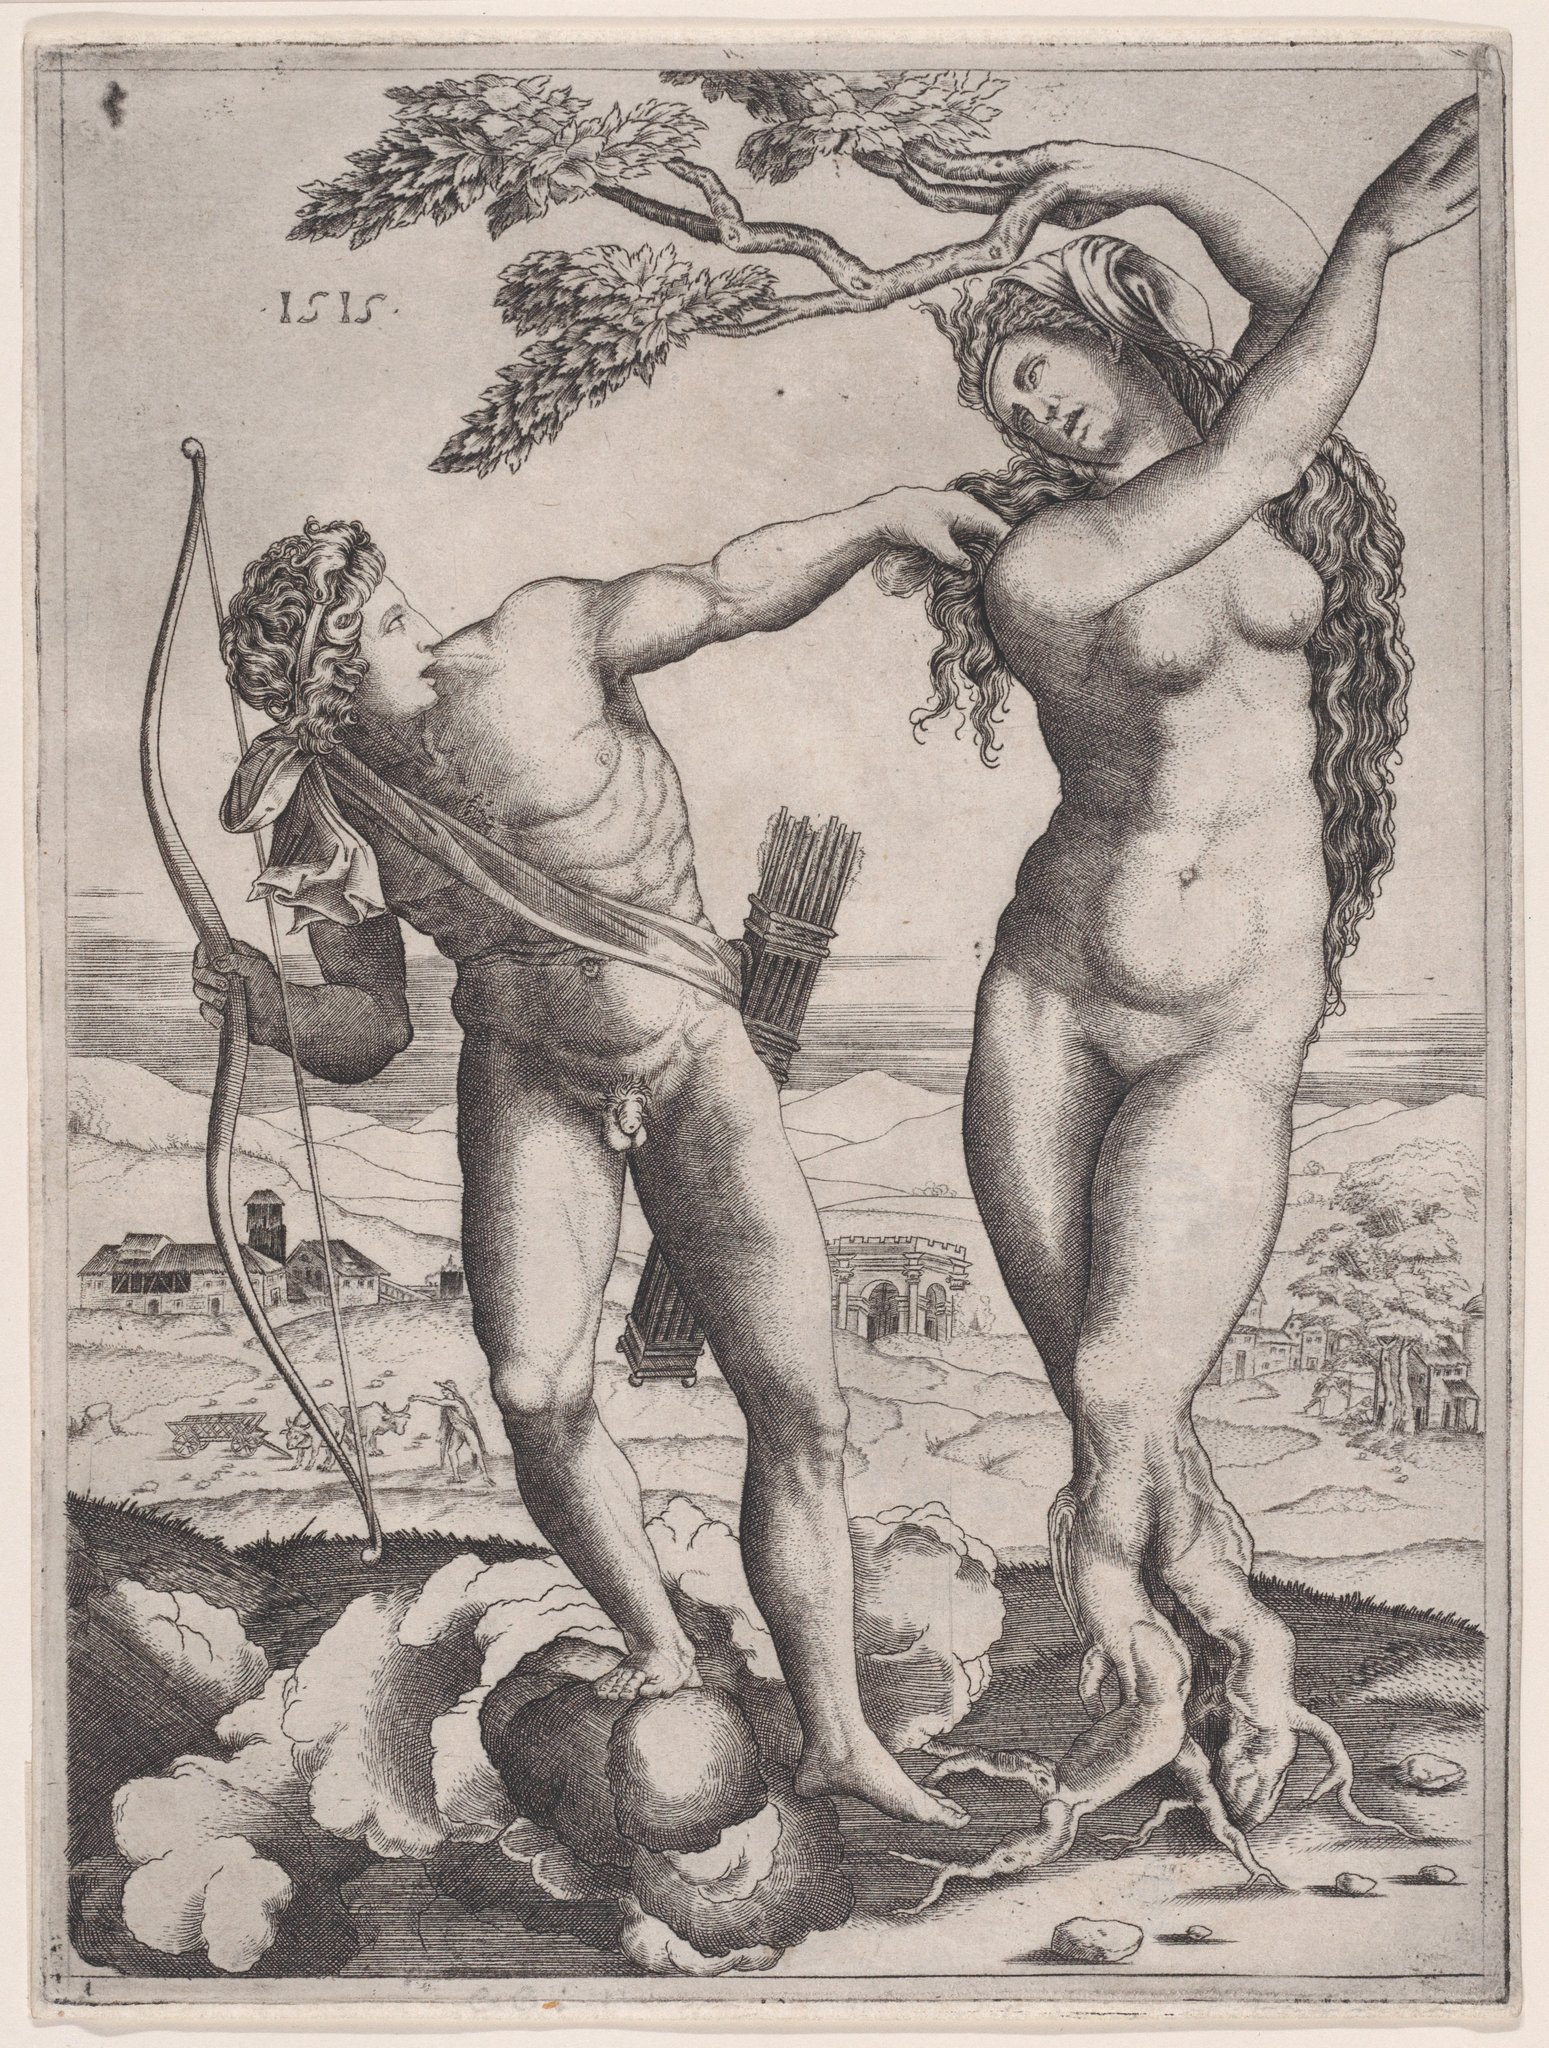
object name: print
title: Apollo and Daphne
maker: agostino veneziano (agostino dei musi)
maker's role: artist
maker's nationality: italian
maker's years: 1490-1536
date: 1515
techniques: engraving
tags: bow and arrow,male nudes,female nudes,apollo,daphne